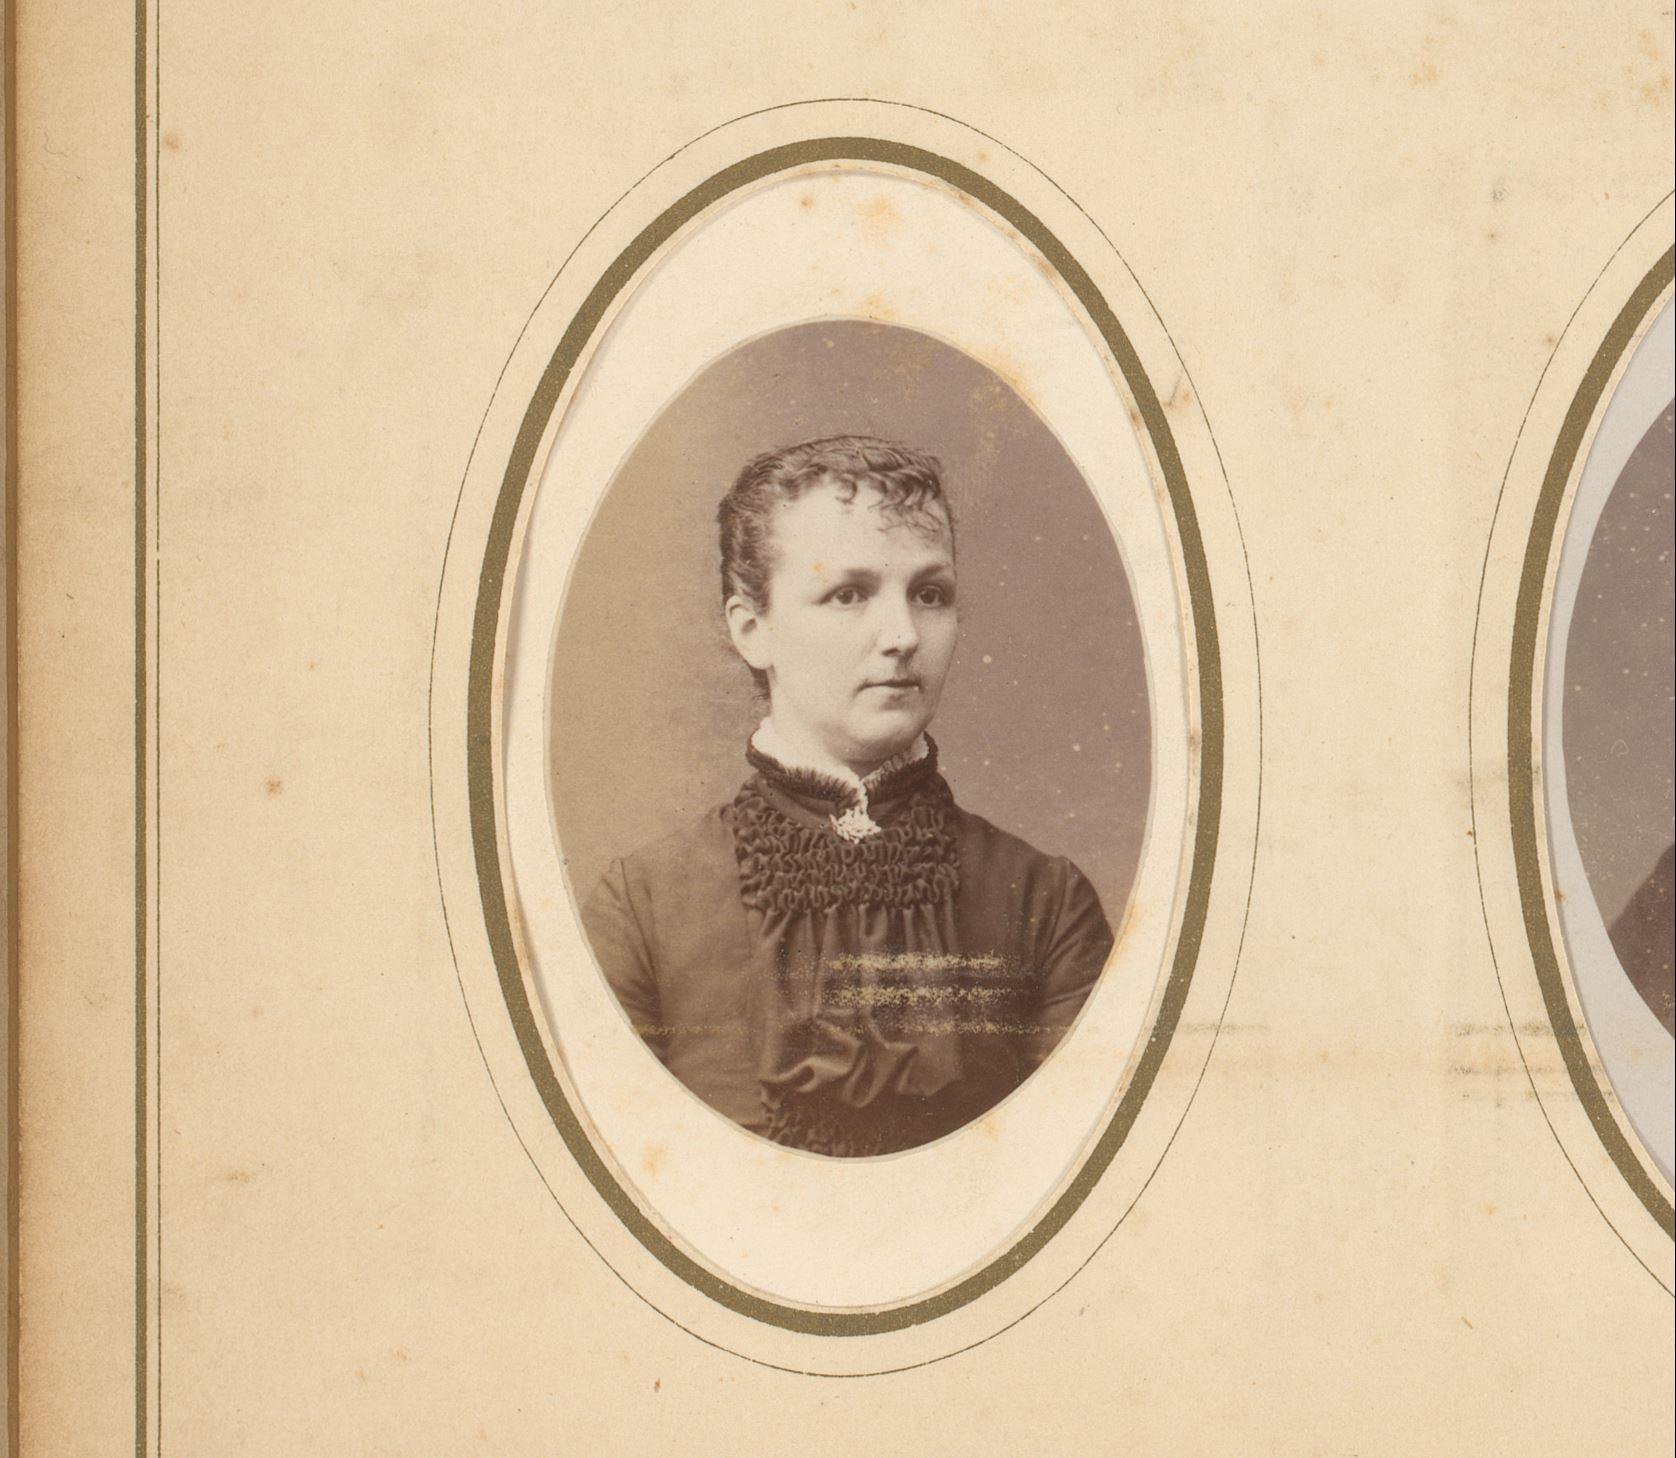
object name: carte de visite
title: Portret van een vrouw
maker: cornelis bernardus broersma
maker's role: fotograaf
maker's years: 1841-1919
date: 1892-1903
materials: cardboard, photographic support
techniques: albumen print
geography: leeuwarden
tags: historical persons - bb - woman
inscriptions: inscription: ‘Photographische Kunstinrichting/ C.B. Broersma/ Willemskade Noord Zyde F. 12/ bij de/ Prins Hendriksbrug/ LEEUWARDEN.’